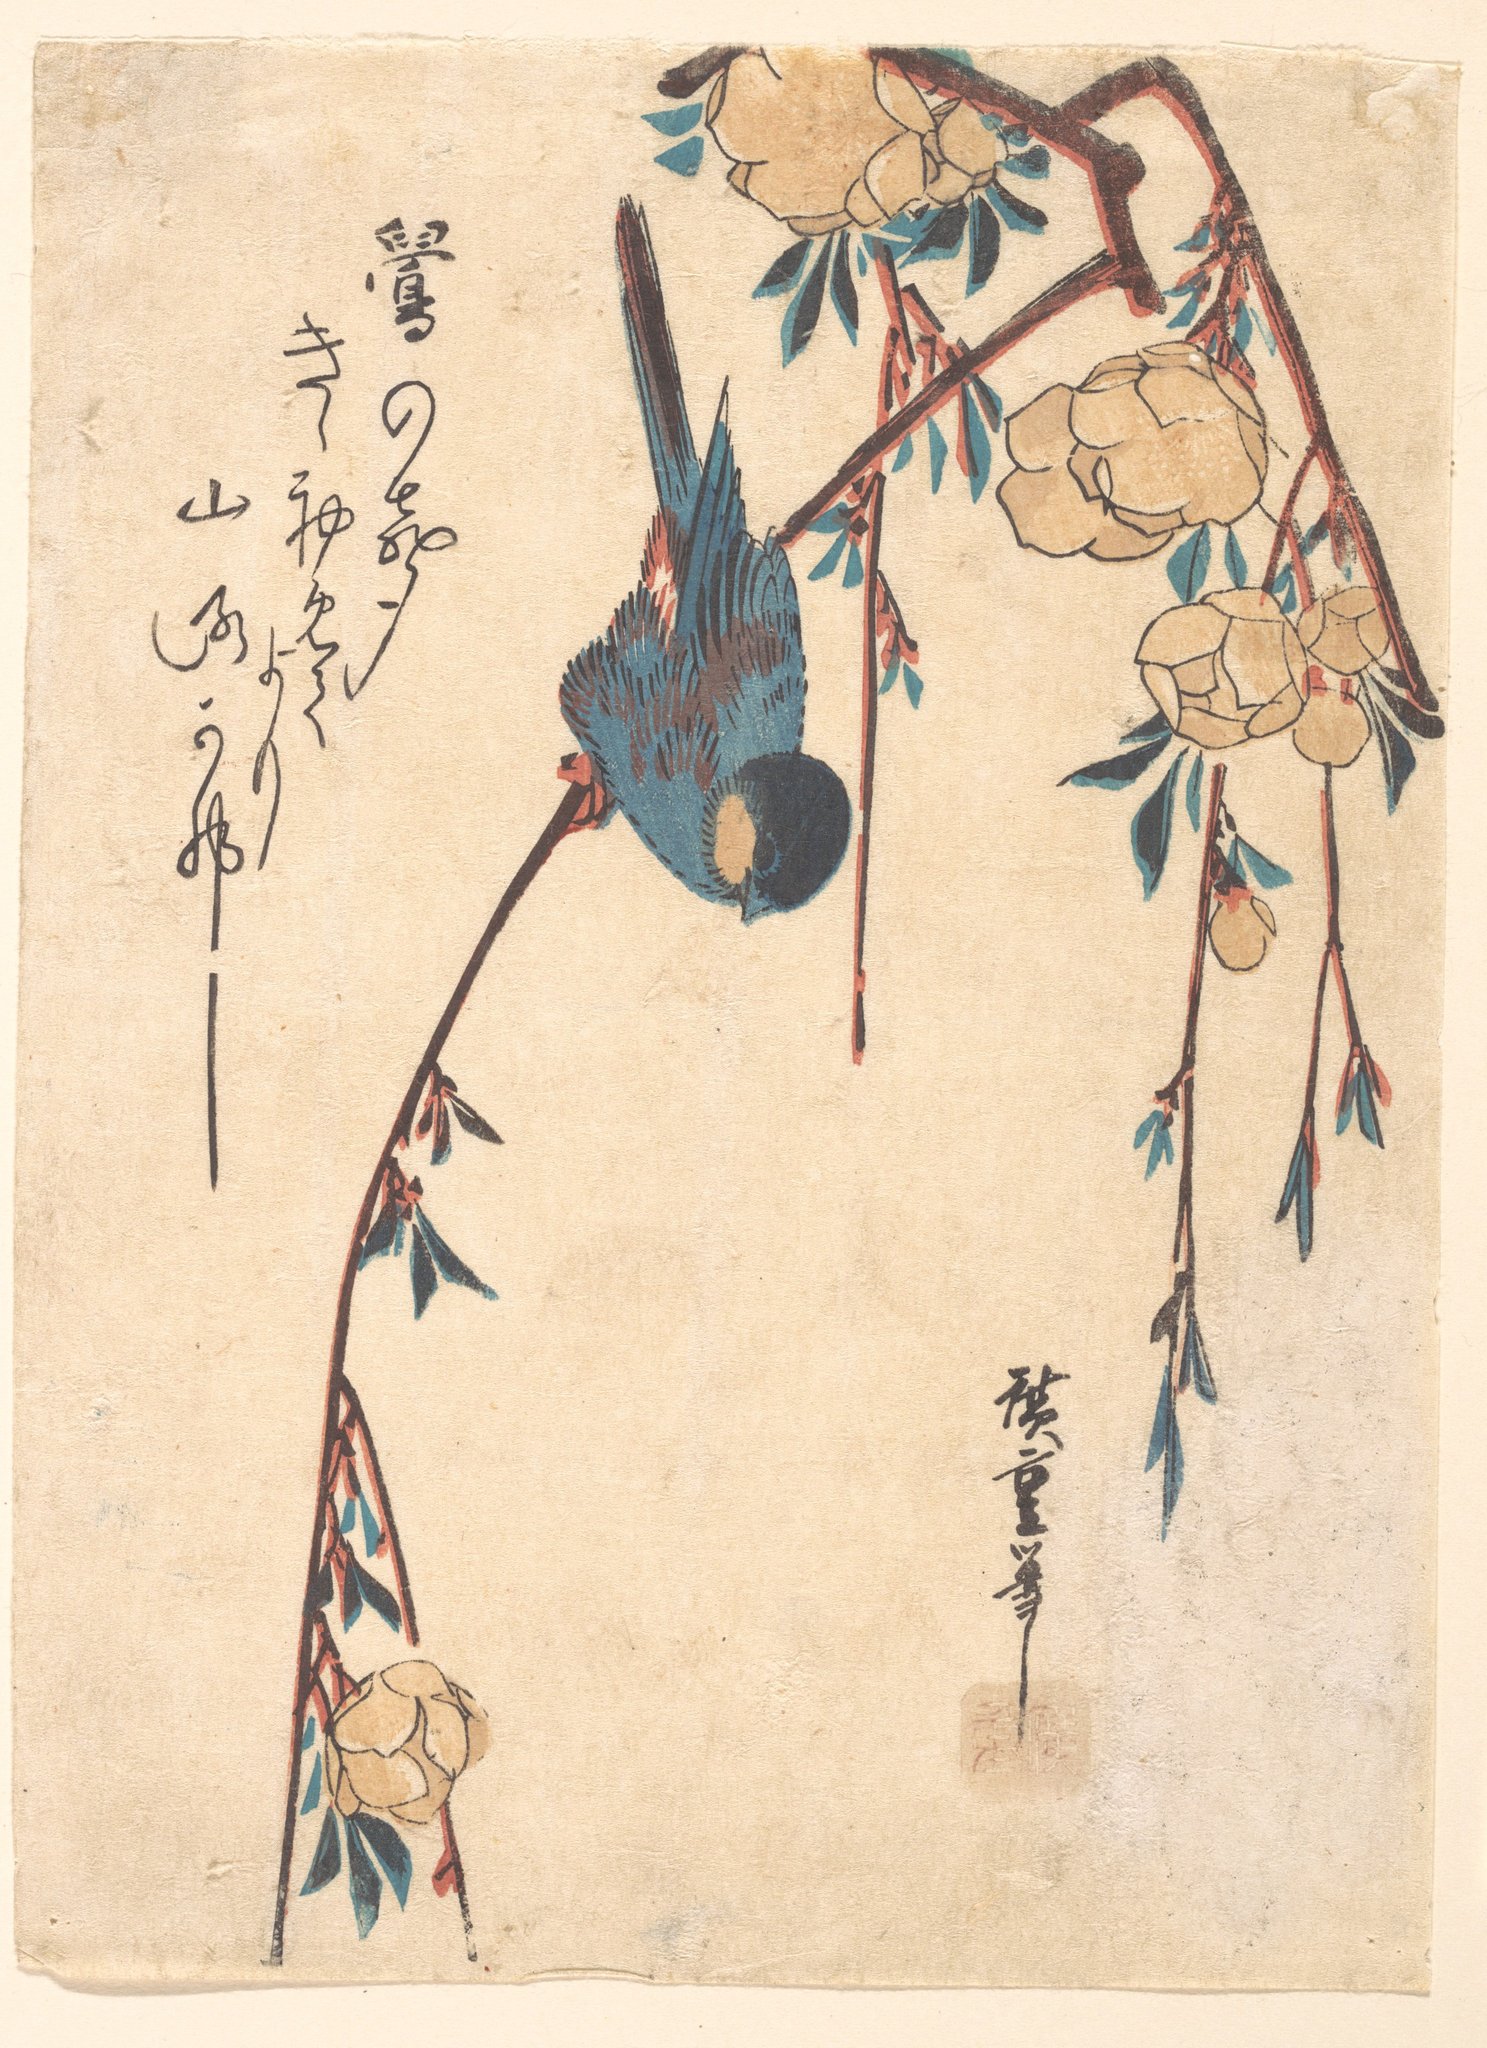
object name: print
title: Weeping Cherry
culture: japanese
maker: utagawa hiroshige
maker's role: artist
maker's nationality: japanese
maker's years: 1797-1858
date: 1797-1858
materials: ink, paper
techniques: woodblock print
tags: birds,flowers